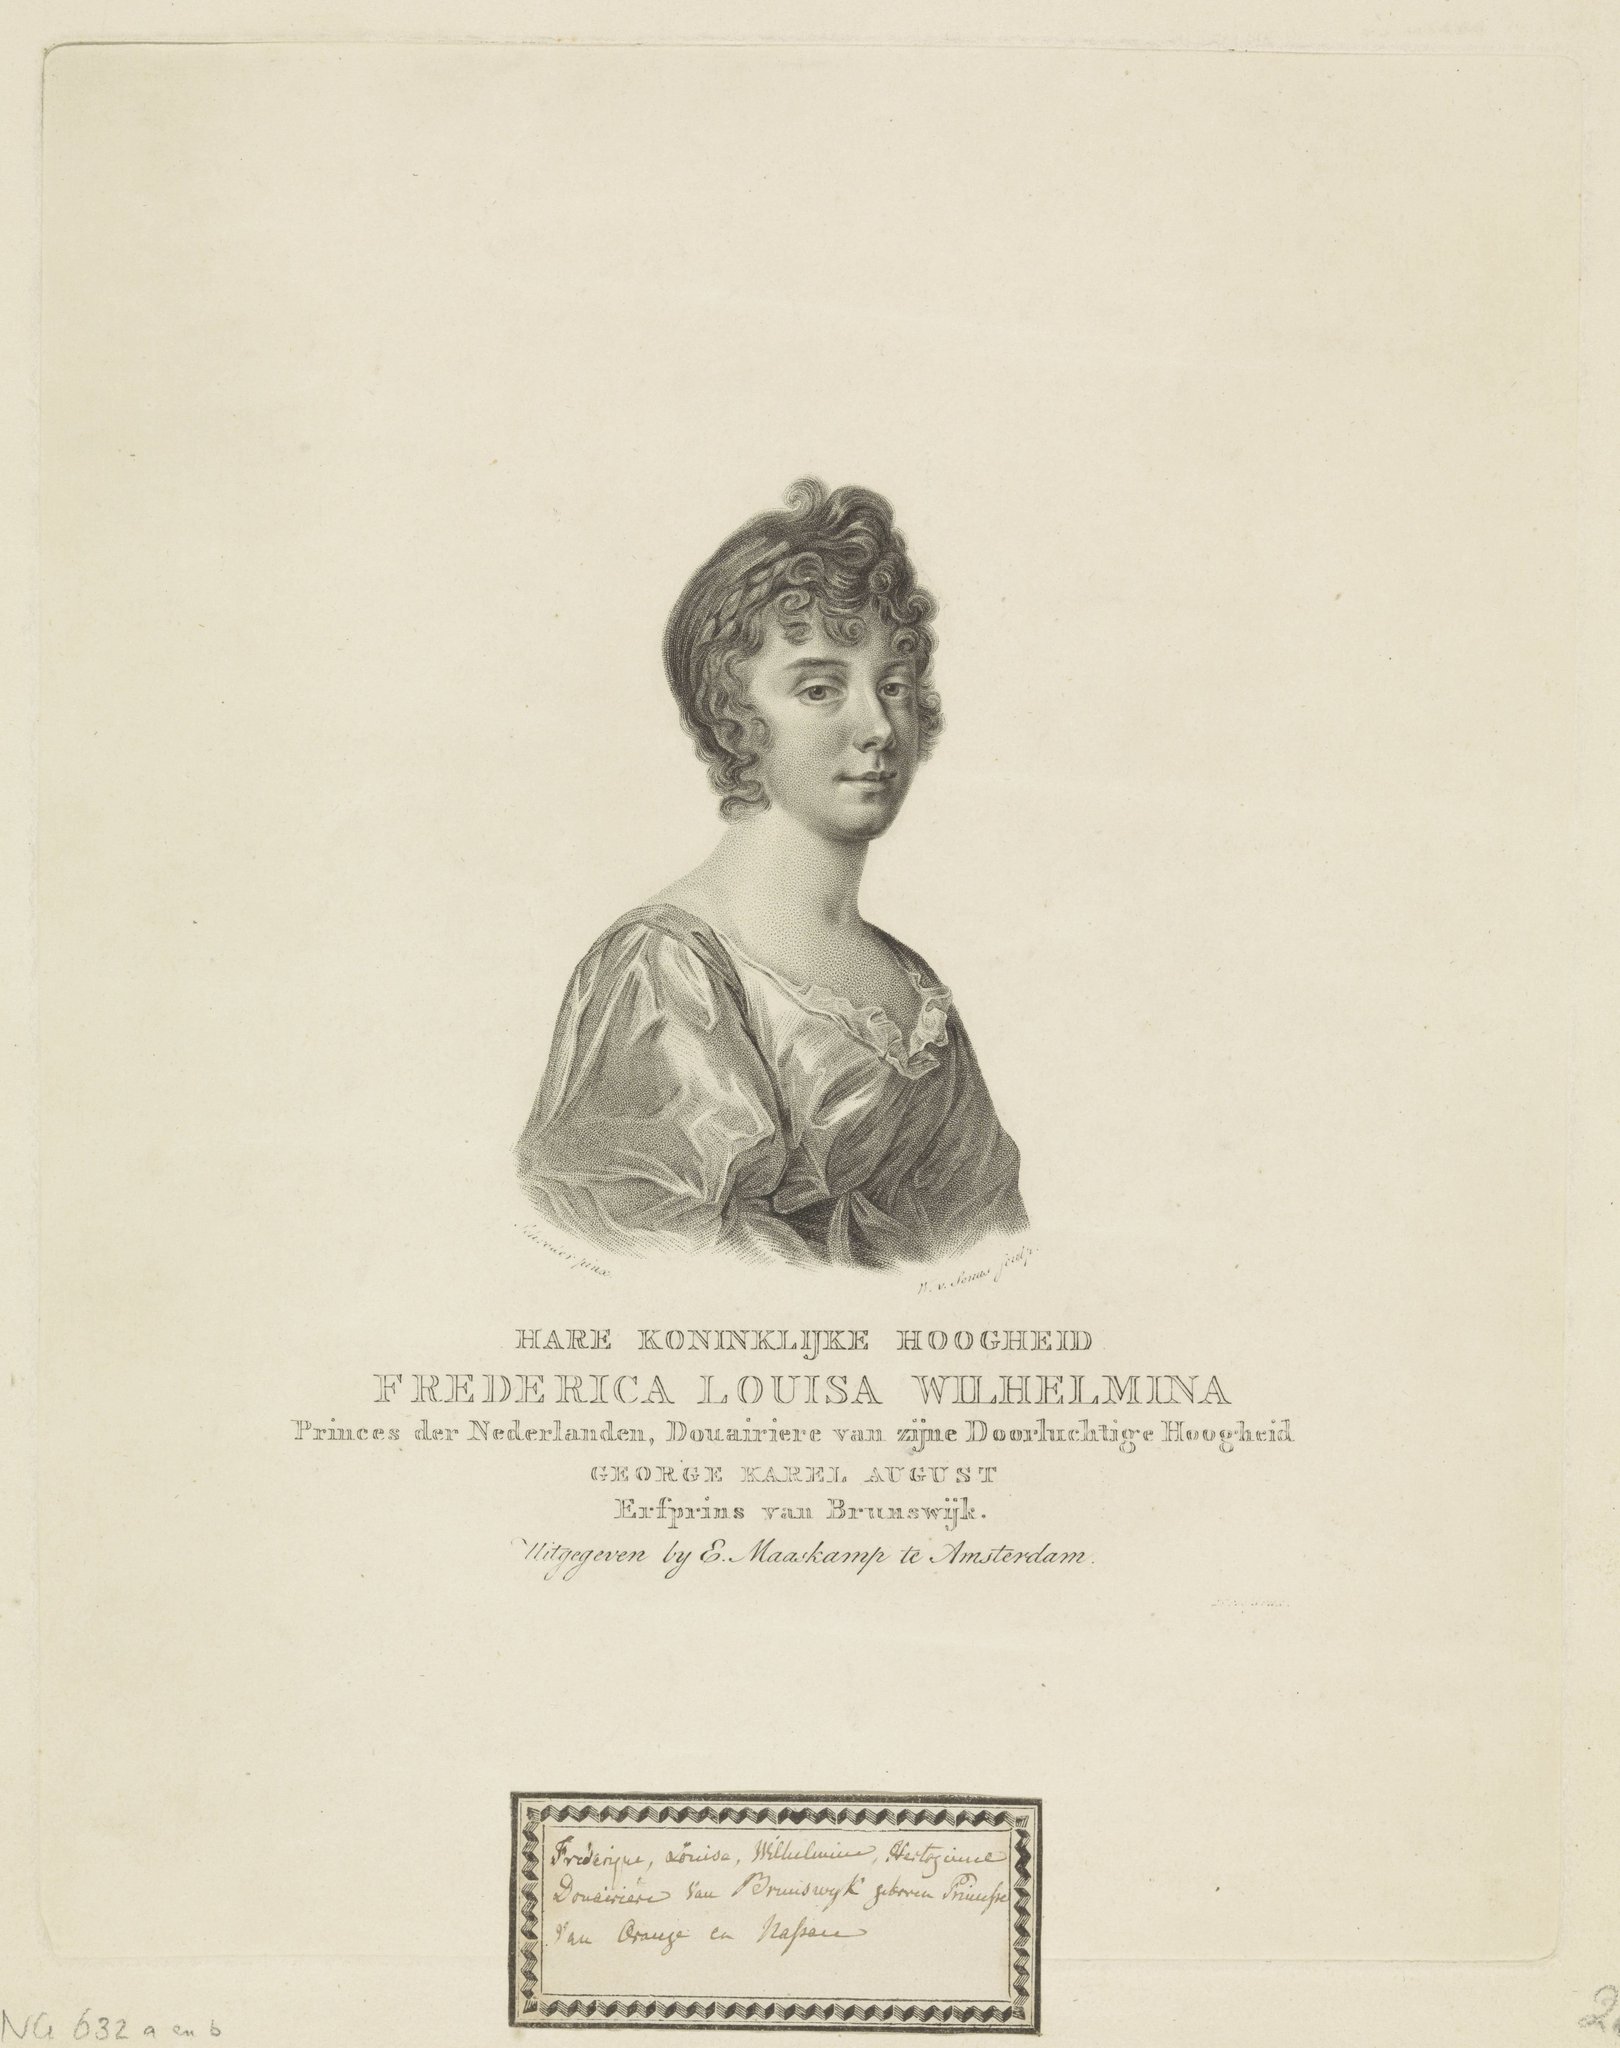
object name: print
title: Portret van Louise, prinses van Oranje-Nassau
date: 1806-1834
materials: paper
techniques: engraving, etching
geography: northern netherlands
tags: the hague, amsterdam, louise (prinses van oranje-nassau)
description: De hier vermelde titel verwijst naar de hoogst verkregen titel van de geportretteerde, niet per se naar de titel die de geportretteerde op deze voorstelling draagt.